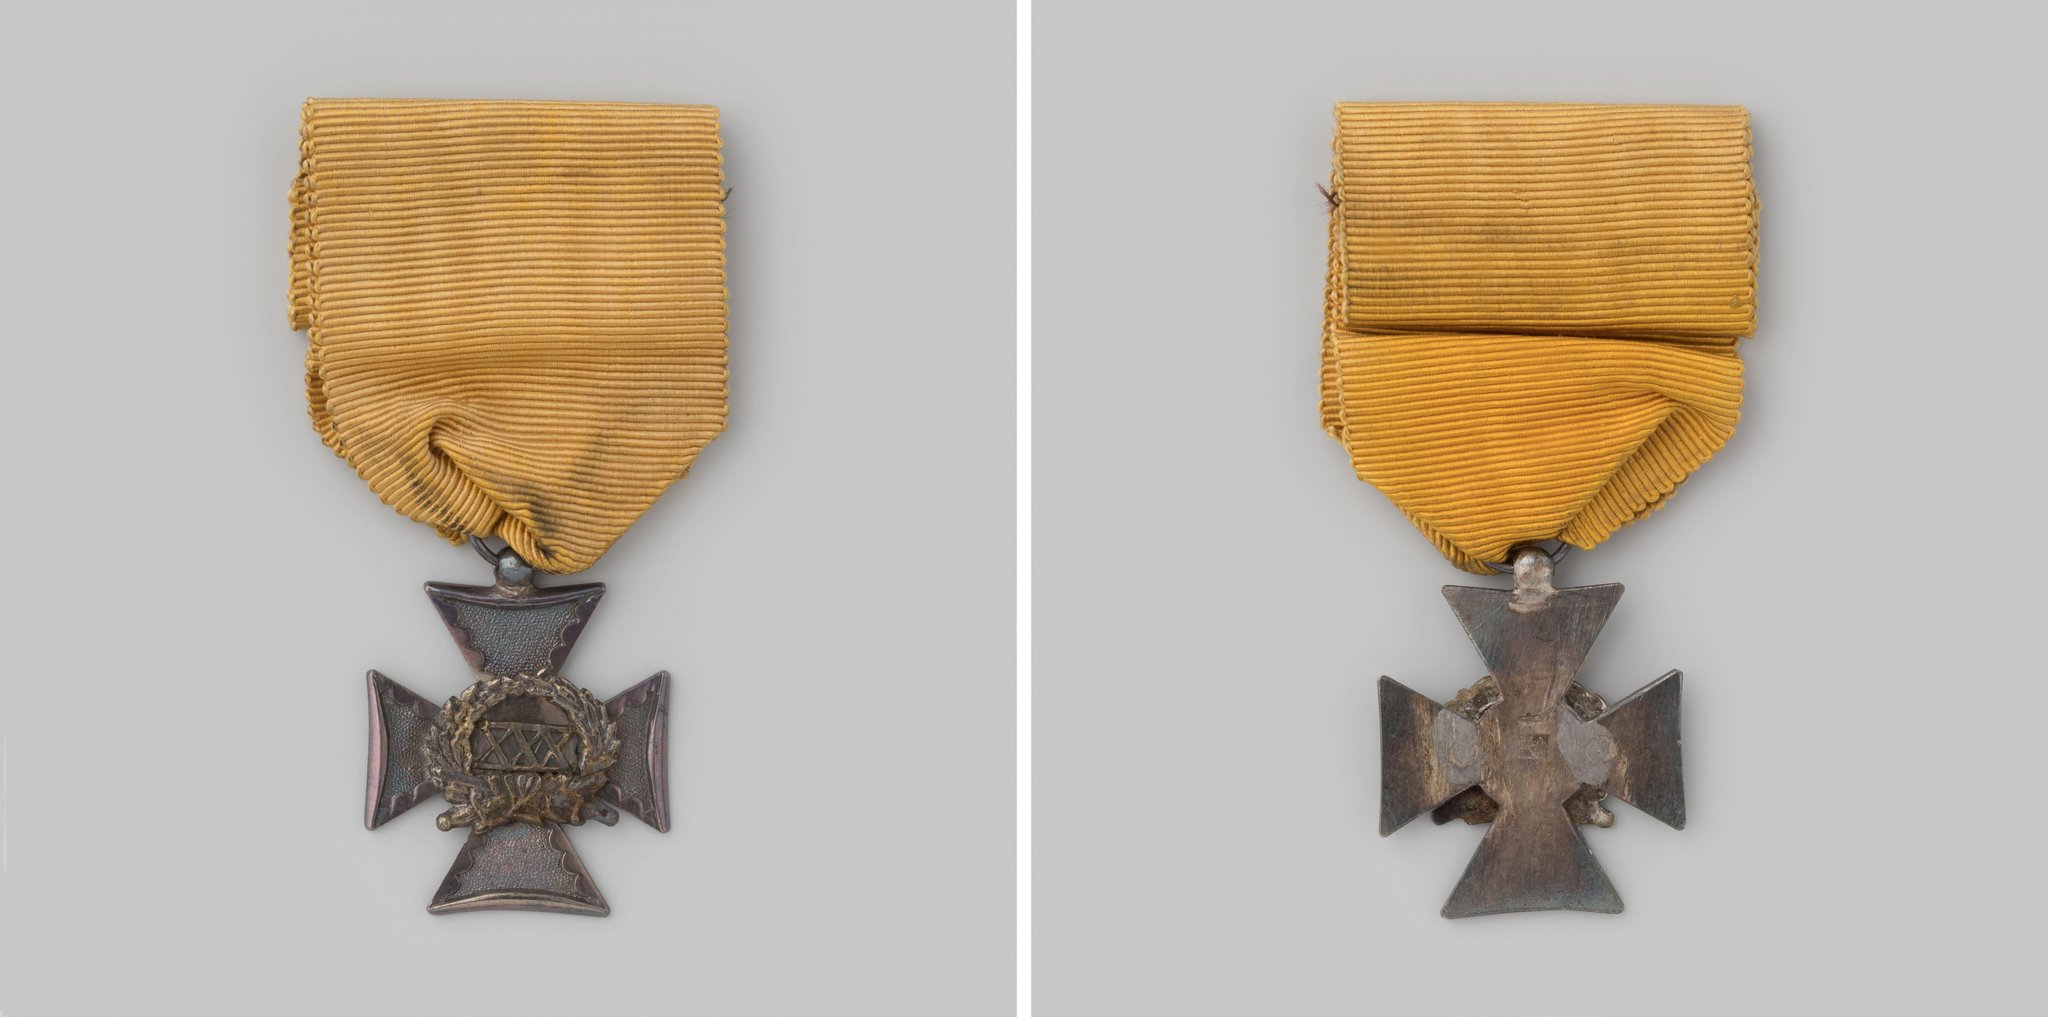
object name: insignia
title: Ereteken (vierarmig kruis) voor eervolle, langdurige en werkelijke dienst bij de schutterij als officier, dertig dienstjaren, gedragen door jhr. D. Bicker, kolonel-commandant te Amsterdam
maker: Anonymous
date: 1866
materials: silver, textile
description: Zilveren draagpenning met knop, ring en lint.